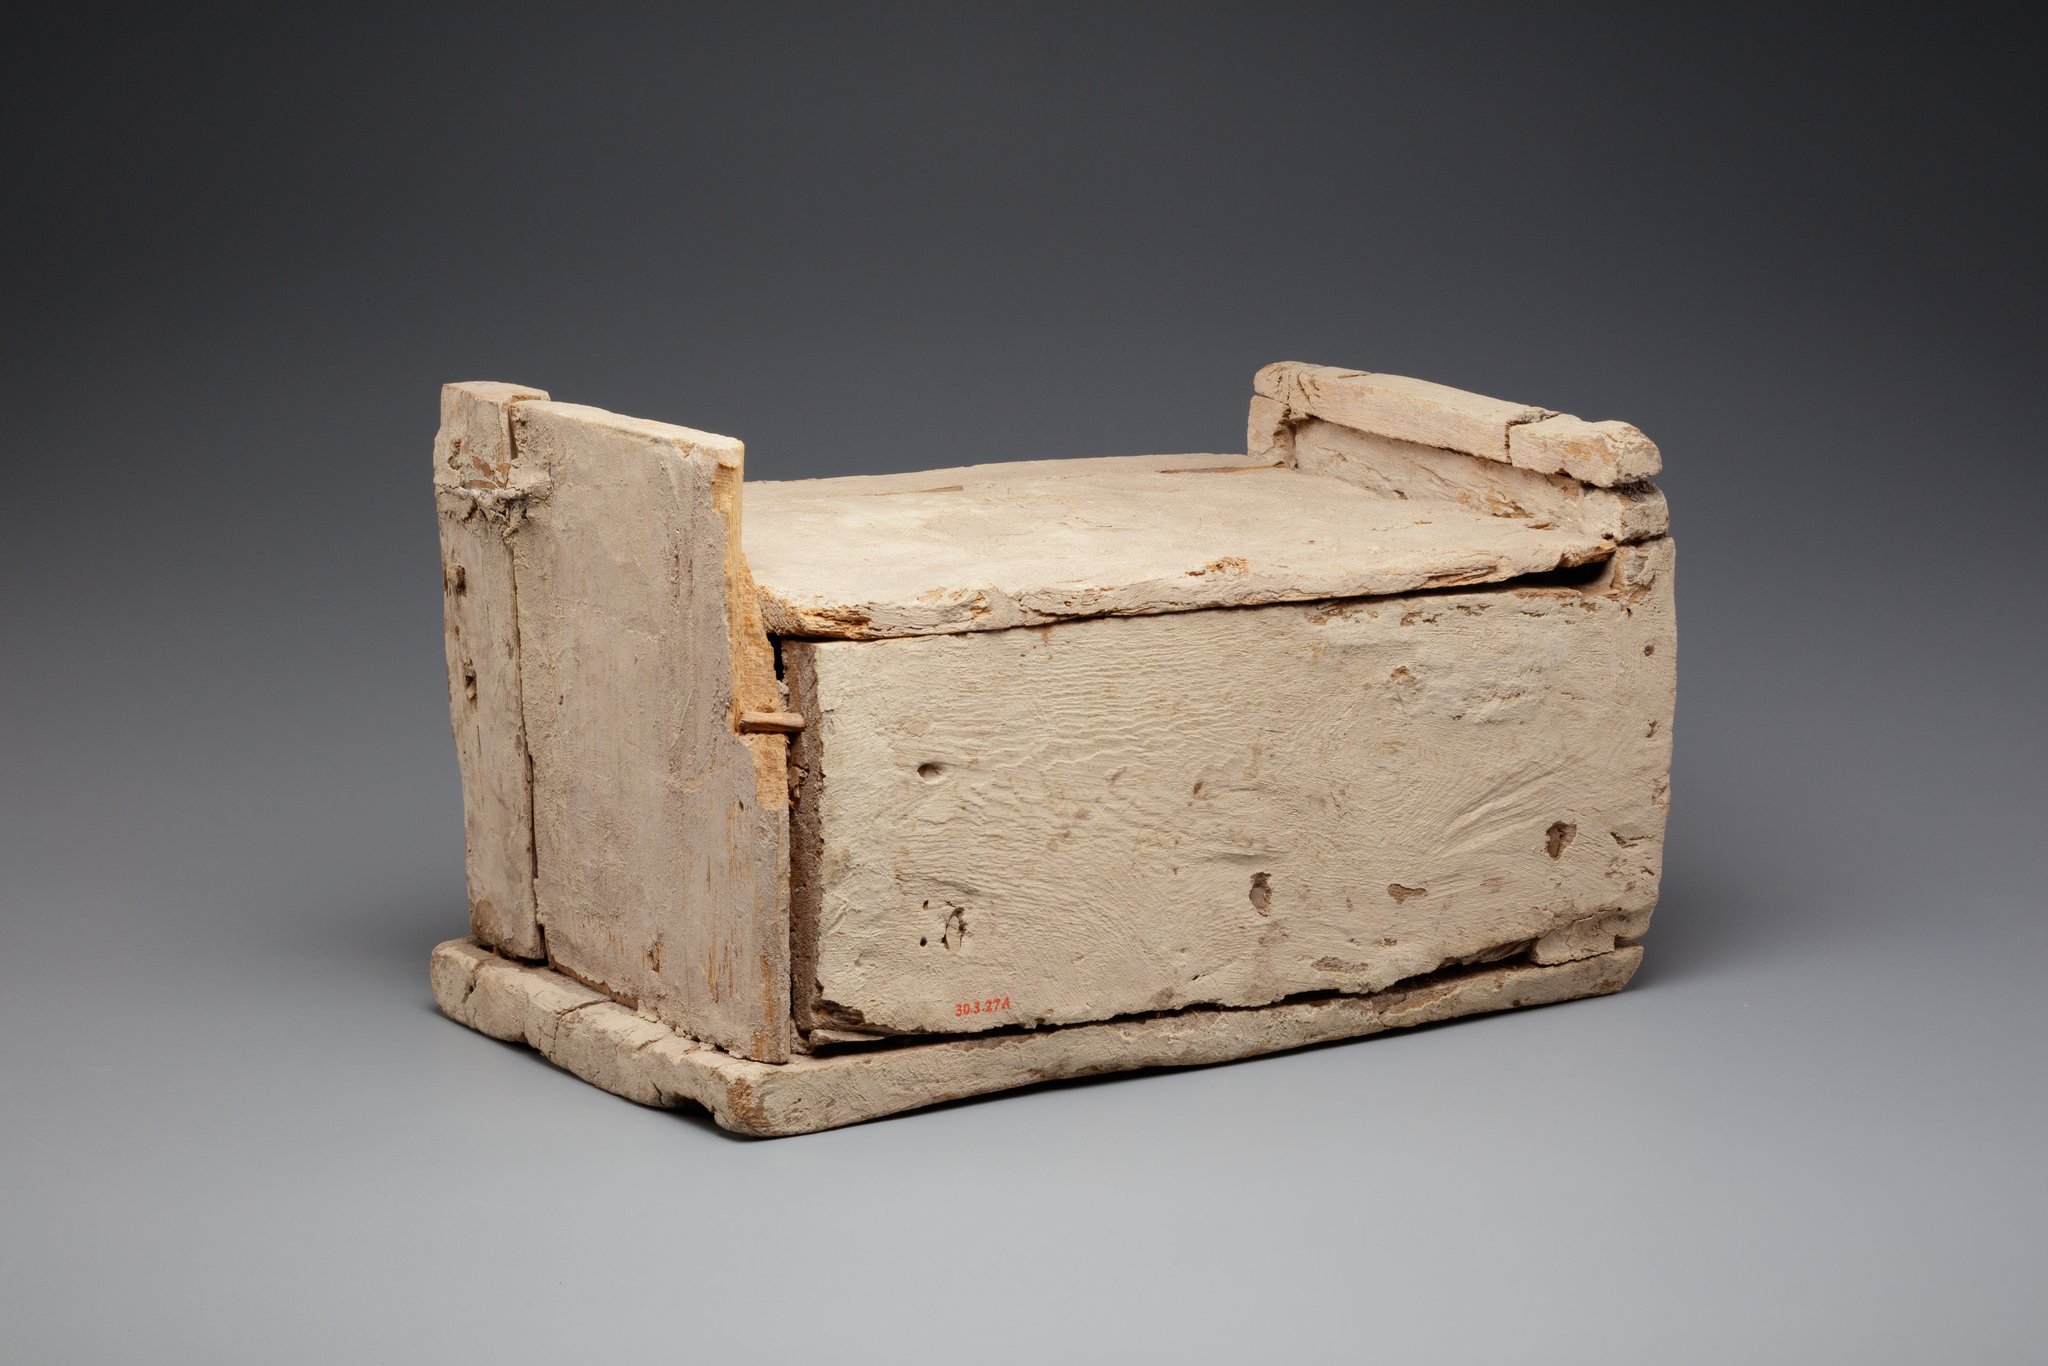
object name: shabti box, nauny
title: Shabti Box of Nauny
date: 1050 BCE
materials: paint, plaster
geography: egypt